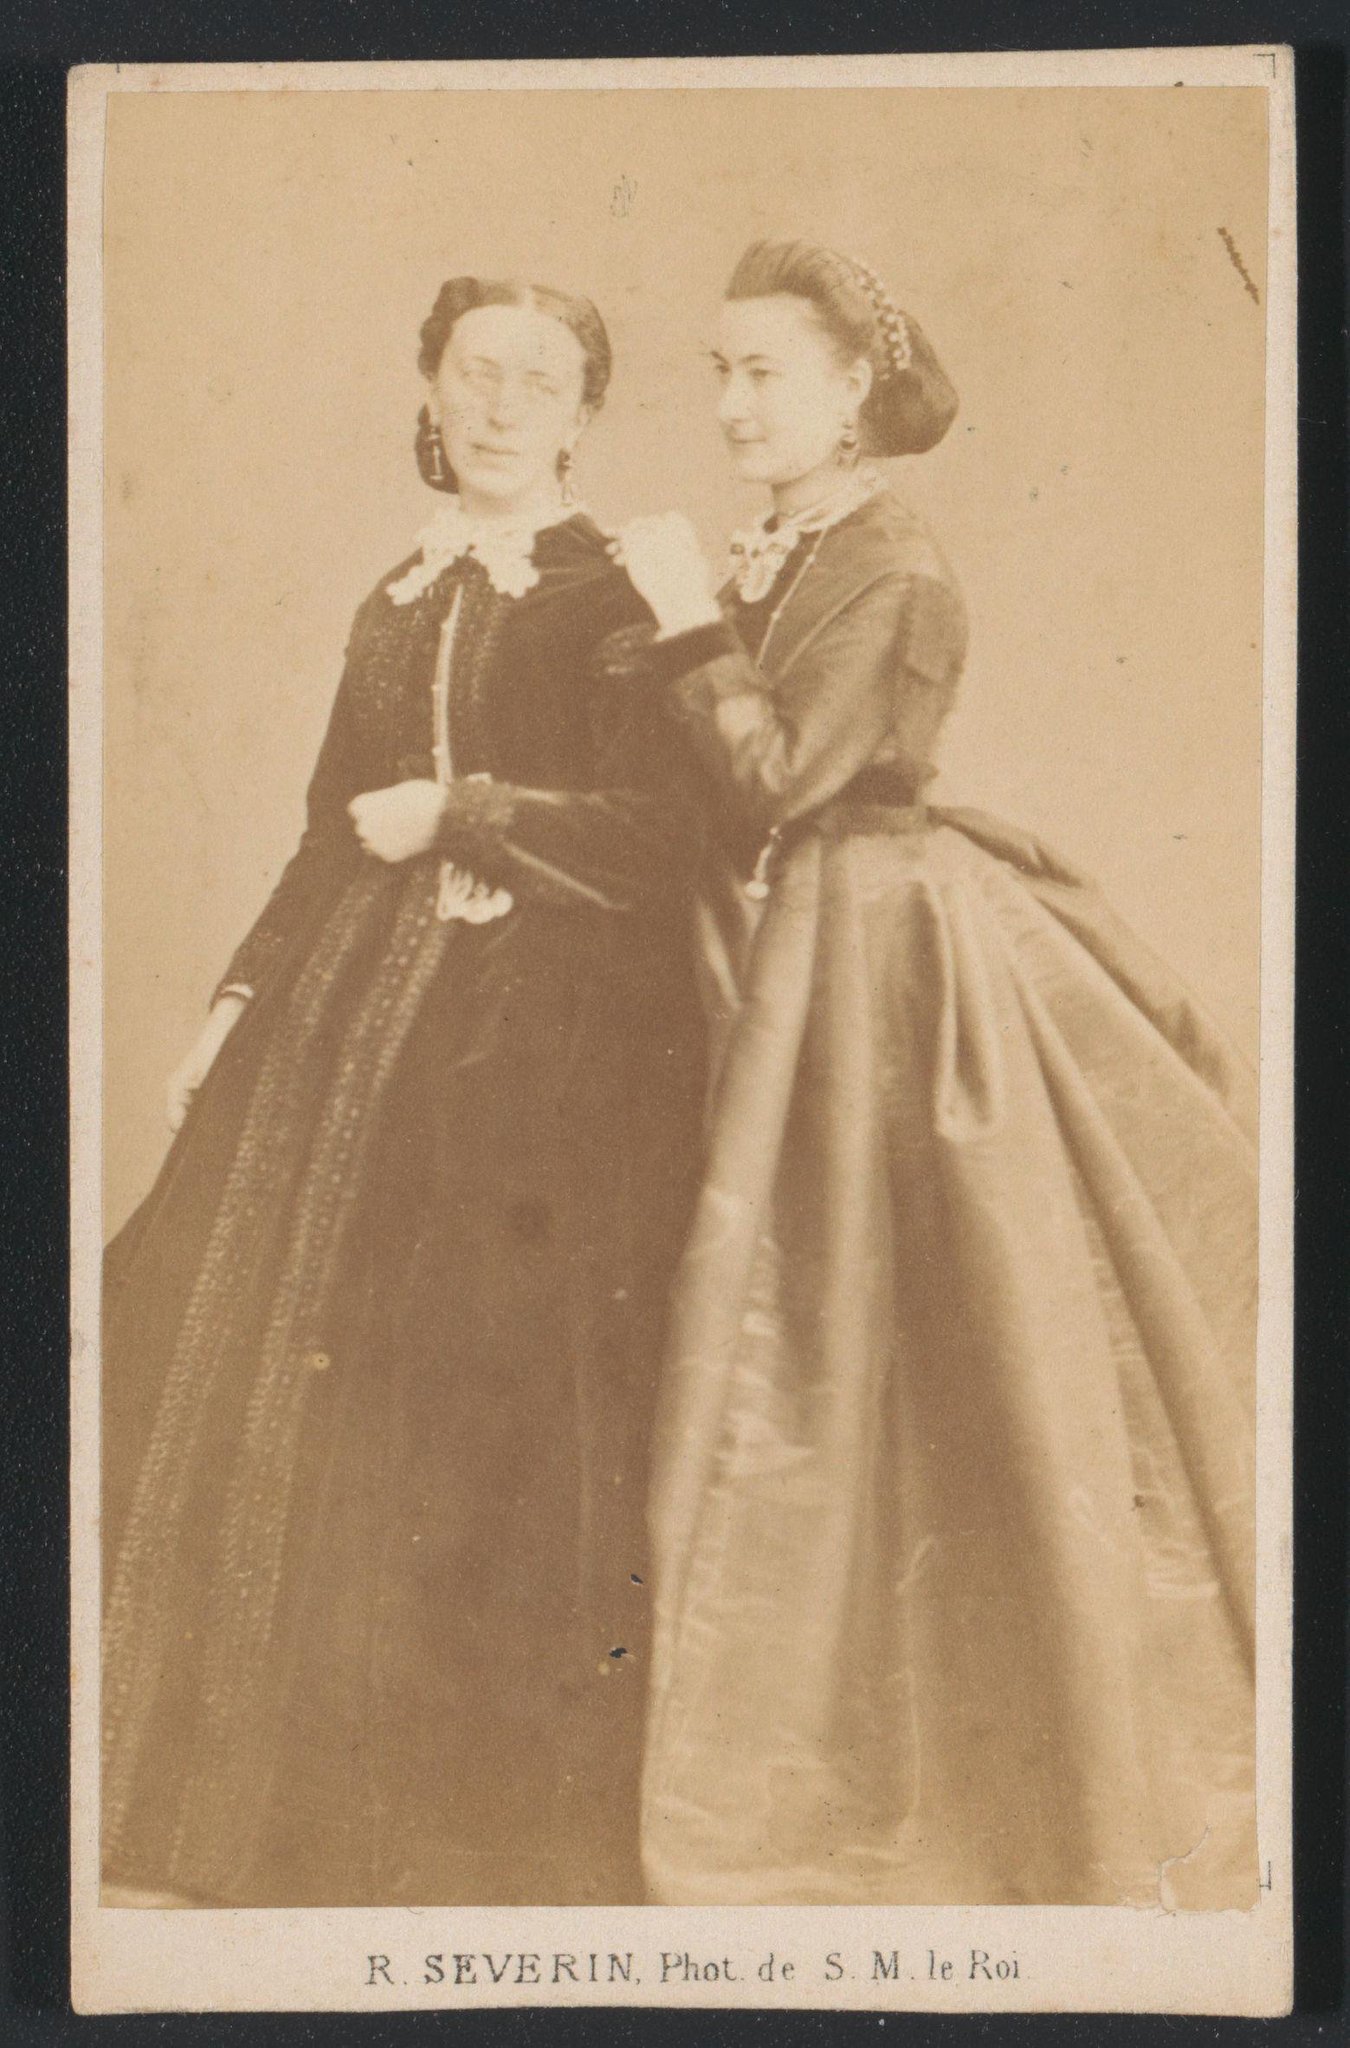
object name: carte de visite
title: Portret van twee vrouwen in lange jurken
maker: robert severin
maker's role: fotograaf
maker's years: 1839-1888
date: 1860-1875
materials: cardboard, paper, photographic support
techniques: albumen print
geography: the hague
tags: studio requisites ~ photographer, historical persons not known by name, the hague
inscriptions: address: ‘Noordeinde, 109. La Haye’